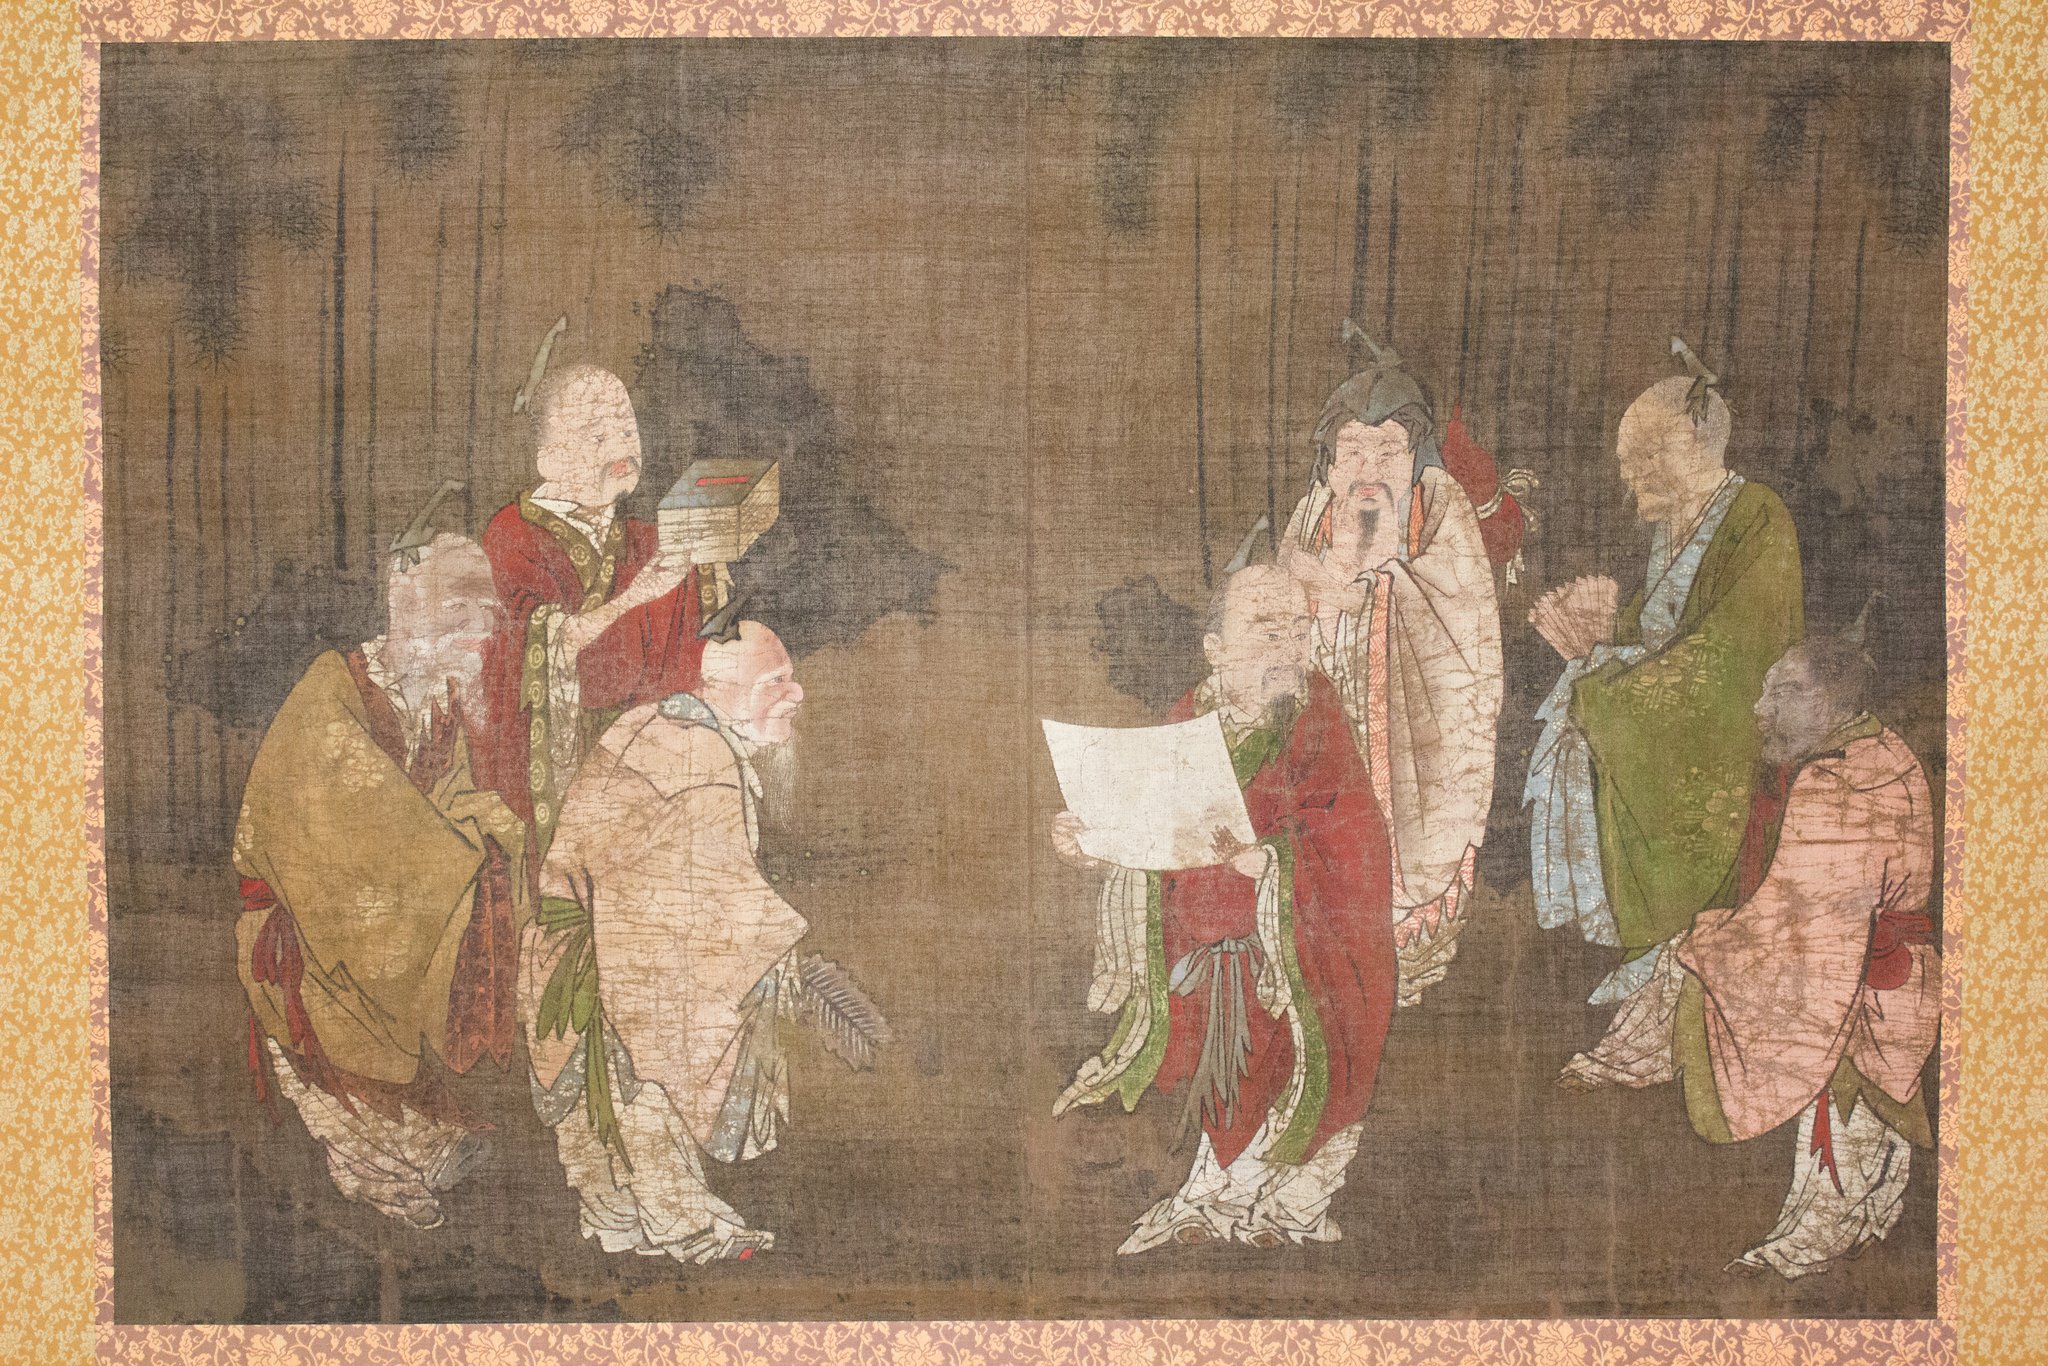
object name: hanging scroll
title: Seven Sages of the Bamboo Grove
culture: japanese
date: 1615-1868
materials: ink, silk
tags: men